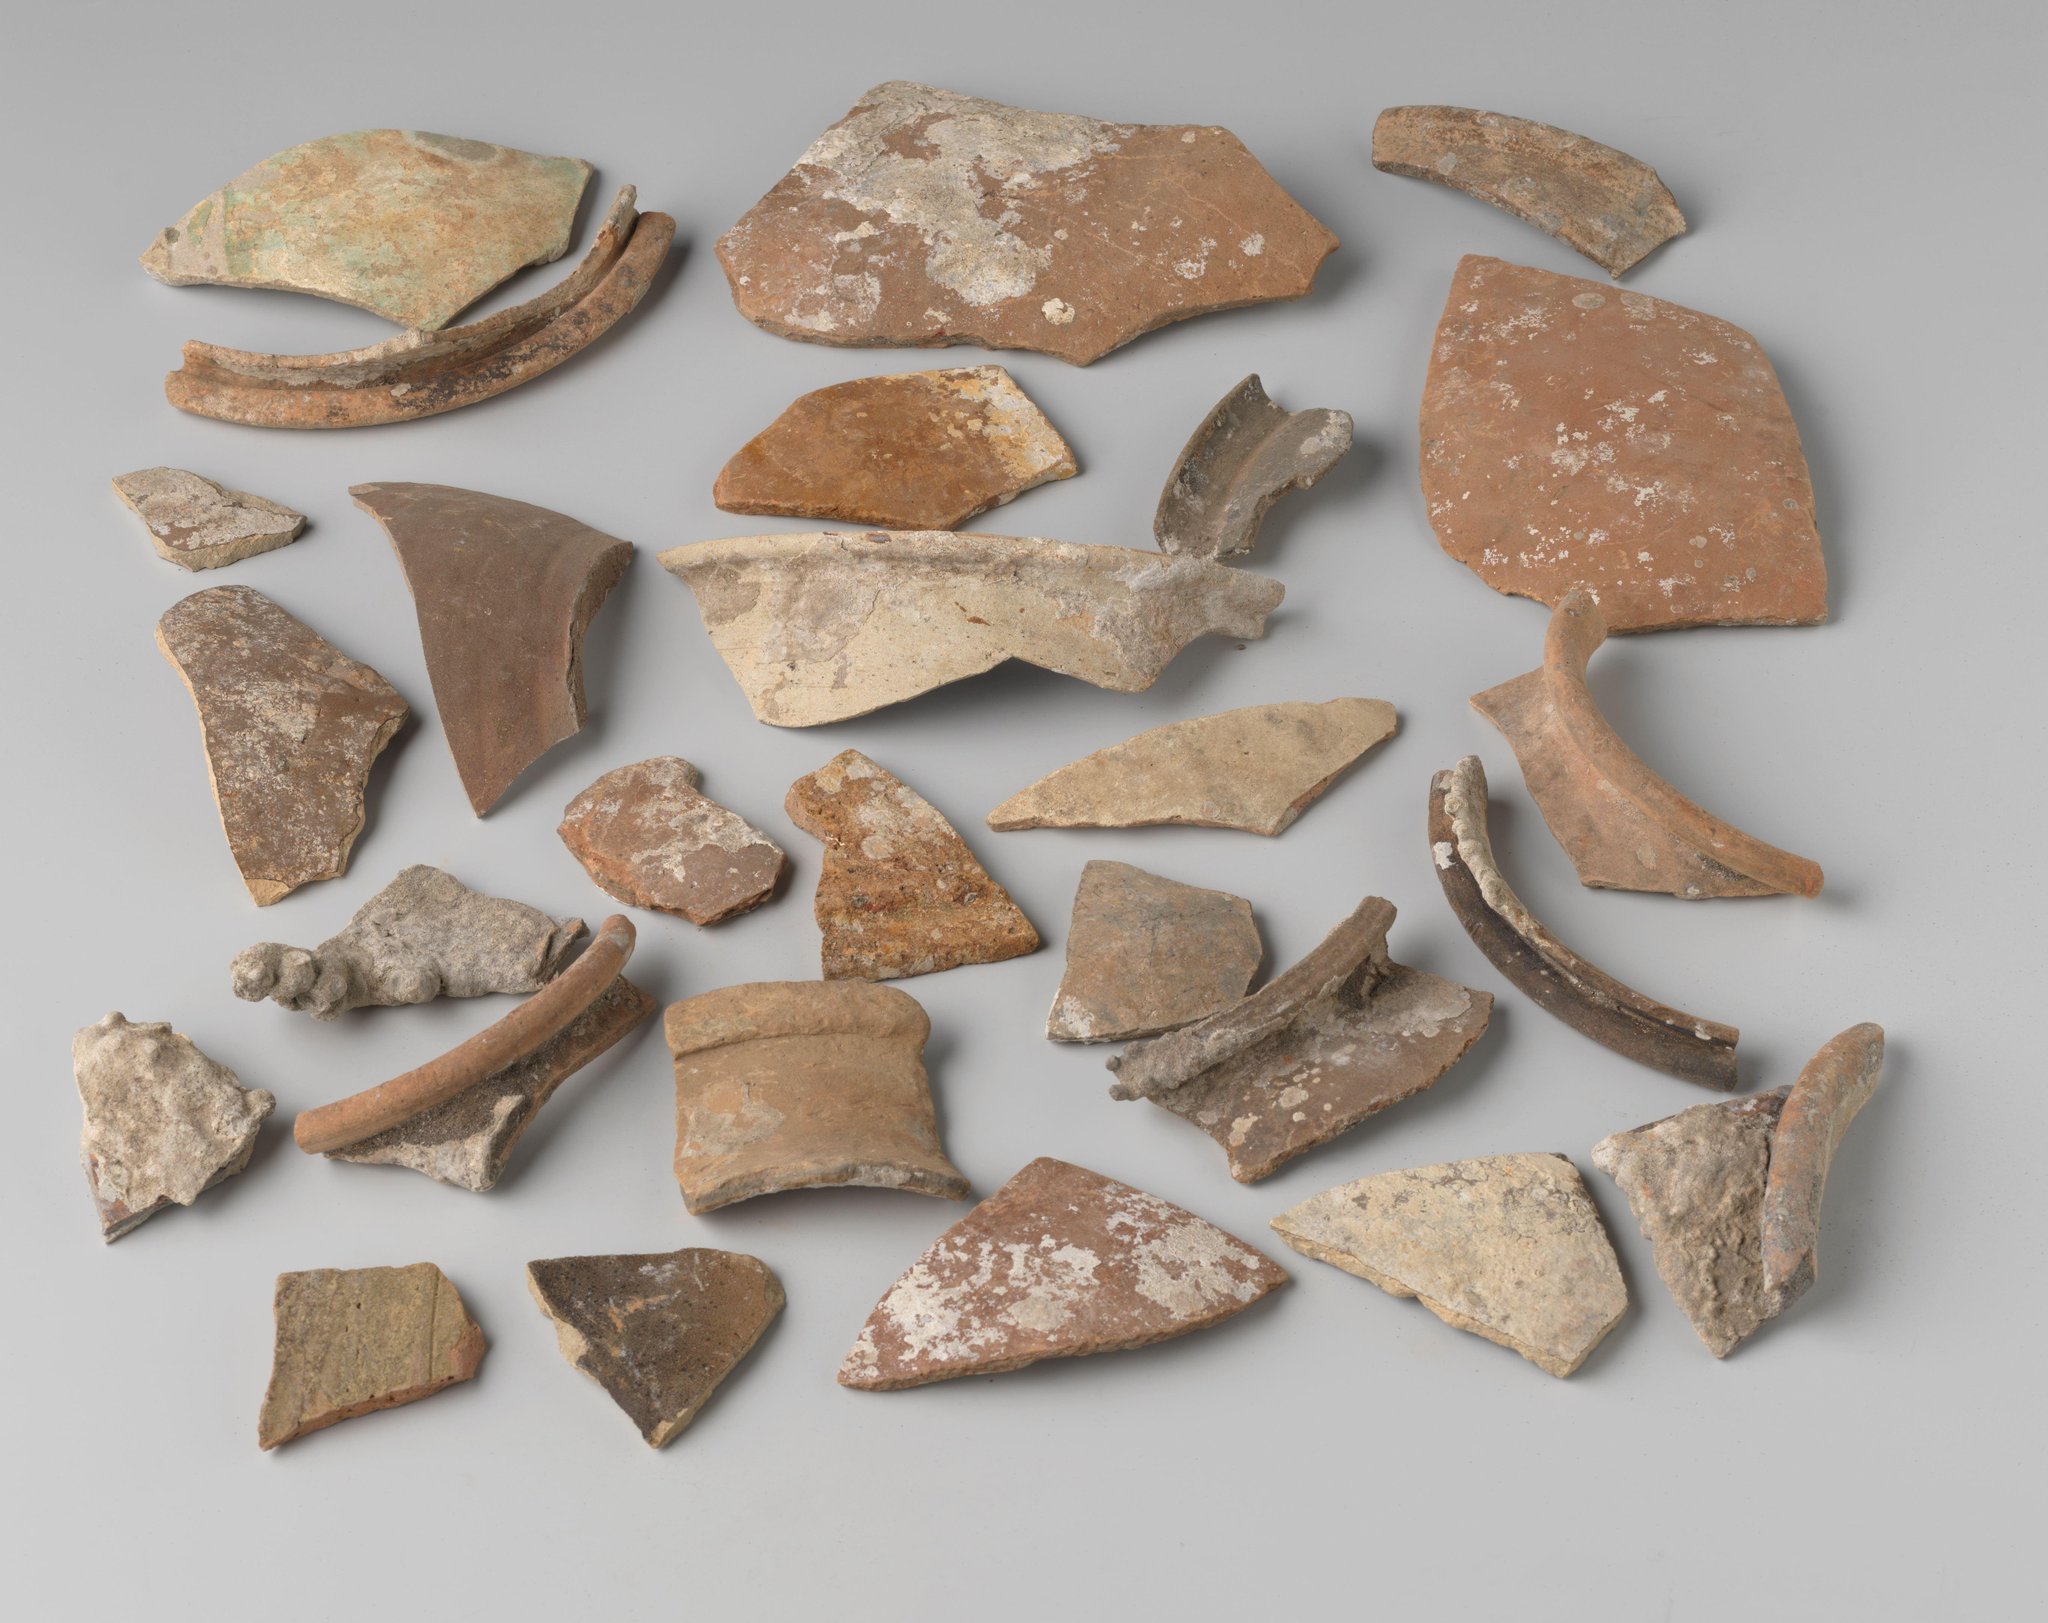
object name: sherd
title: Scherven aardewerk en steengoed uit V.O.C.-schip de 'Witte Leeuw'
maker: Anonymous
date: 1613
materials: earthenware, glaze, stoneware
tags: verenigde oostindische compagnie, sint-helena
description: Scherven roodbakkend en witbakkend aardewerk en steengoed, enkele geglazuurd, uit V.O.C.-schip de 'Witte Leeuw'.